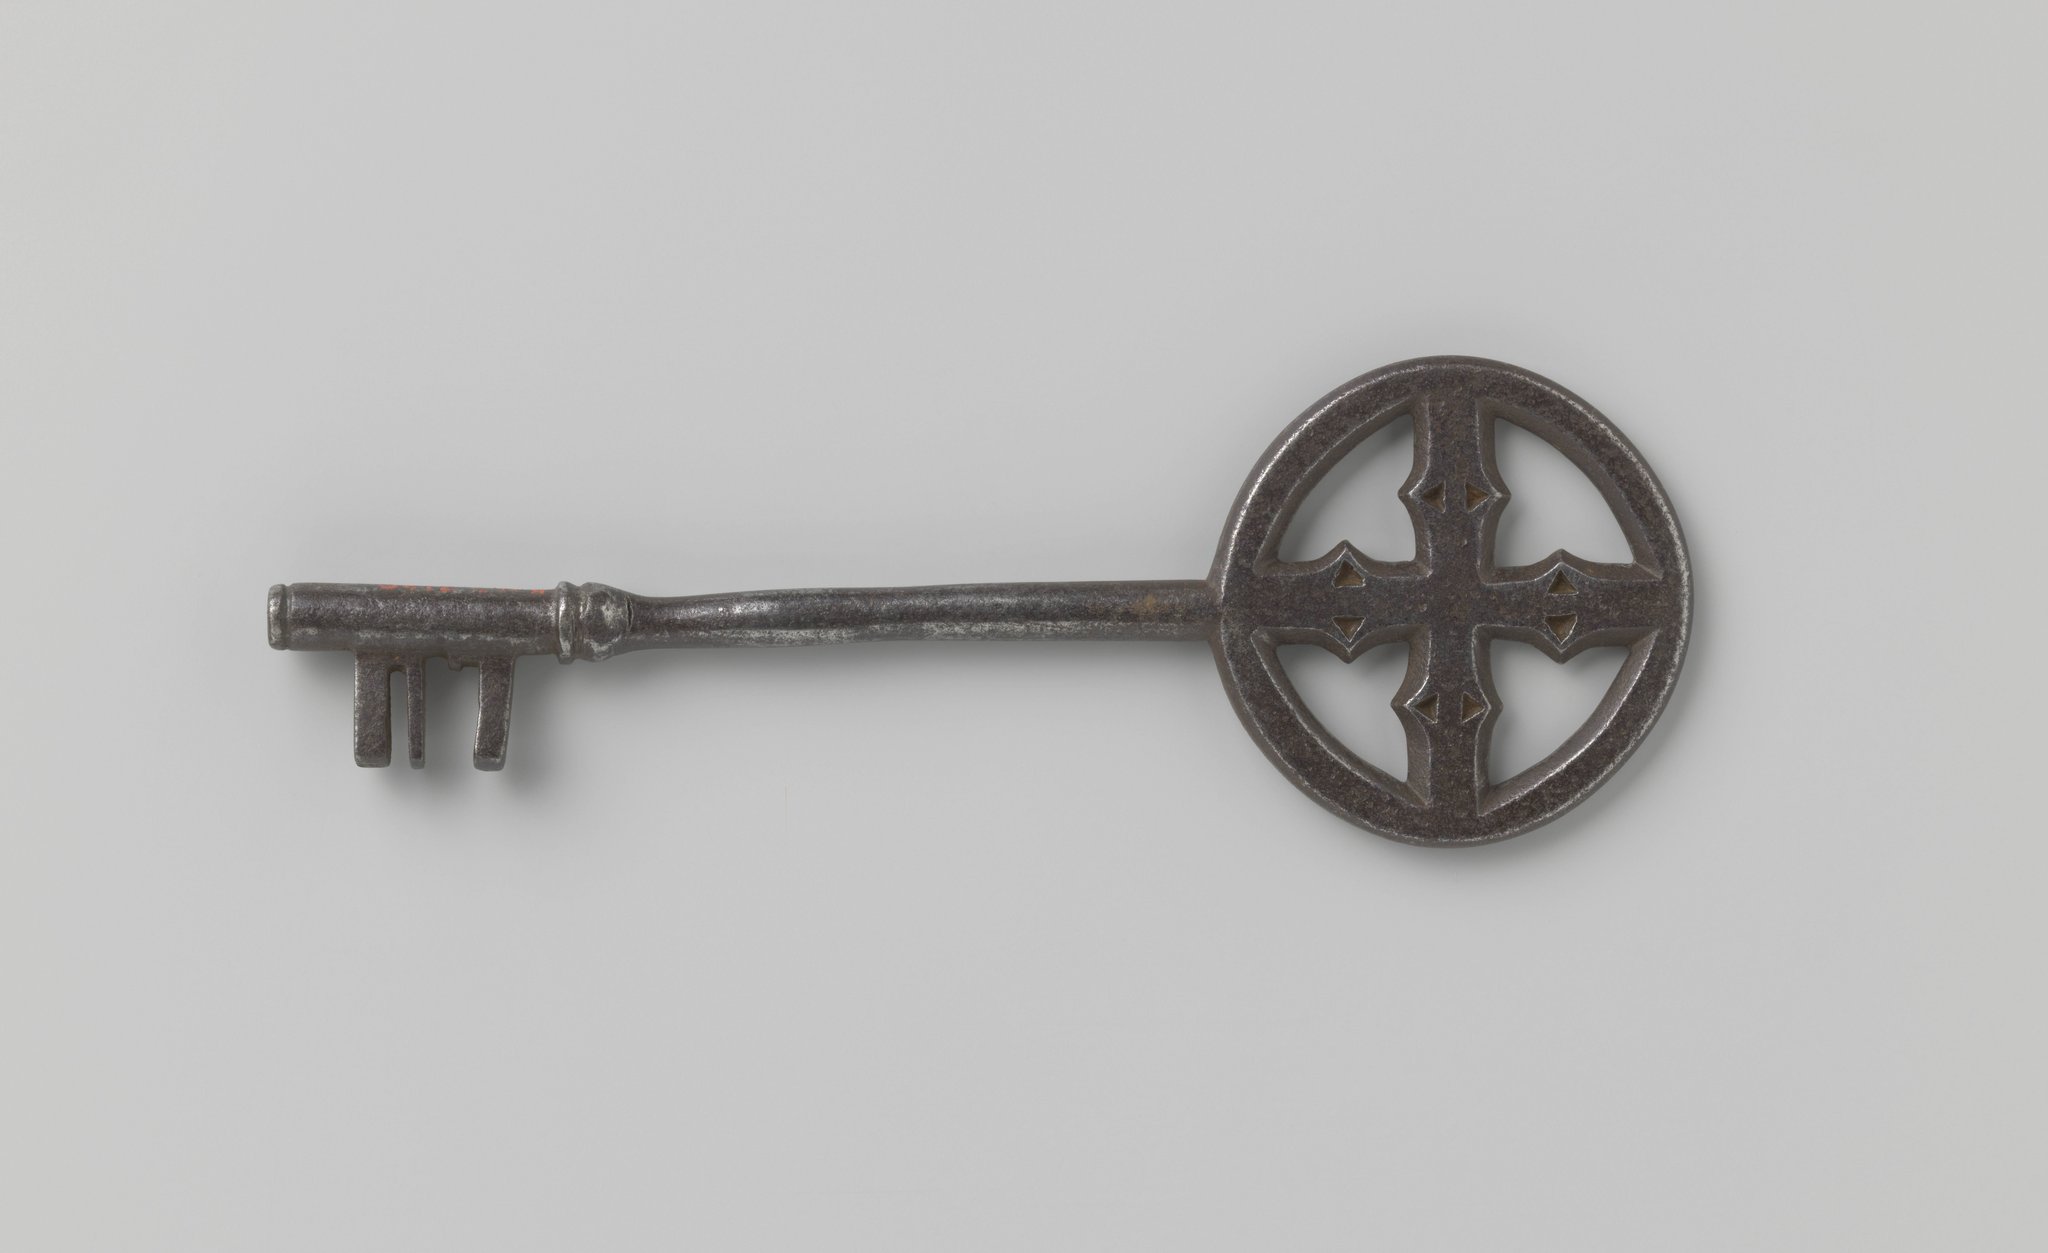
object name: key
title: Sleutel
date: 1600-1699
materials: iron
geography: england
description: Sleutel met grote, ronde greep met kruisvulling, waarin driehoekige verdiepinkjes ingeslagen zijn. De dunne schacht is inderaan geprofileerd. Een van de vier tanden aan de baard ontbreekt.